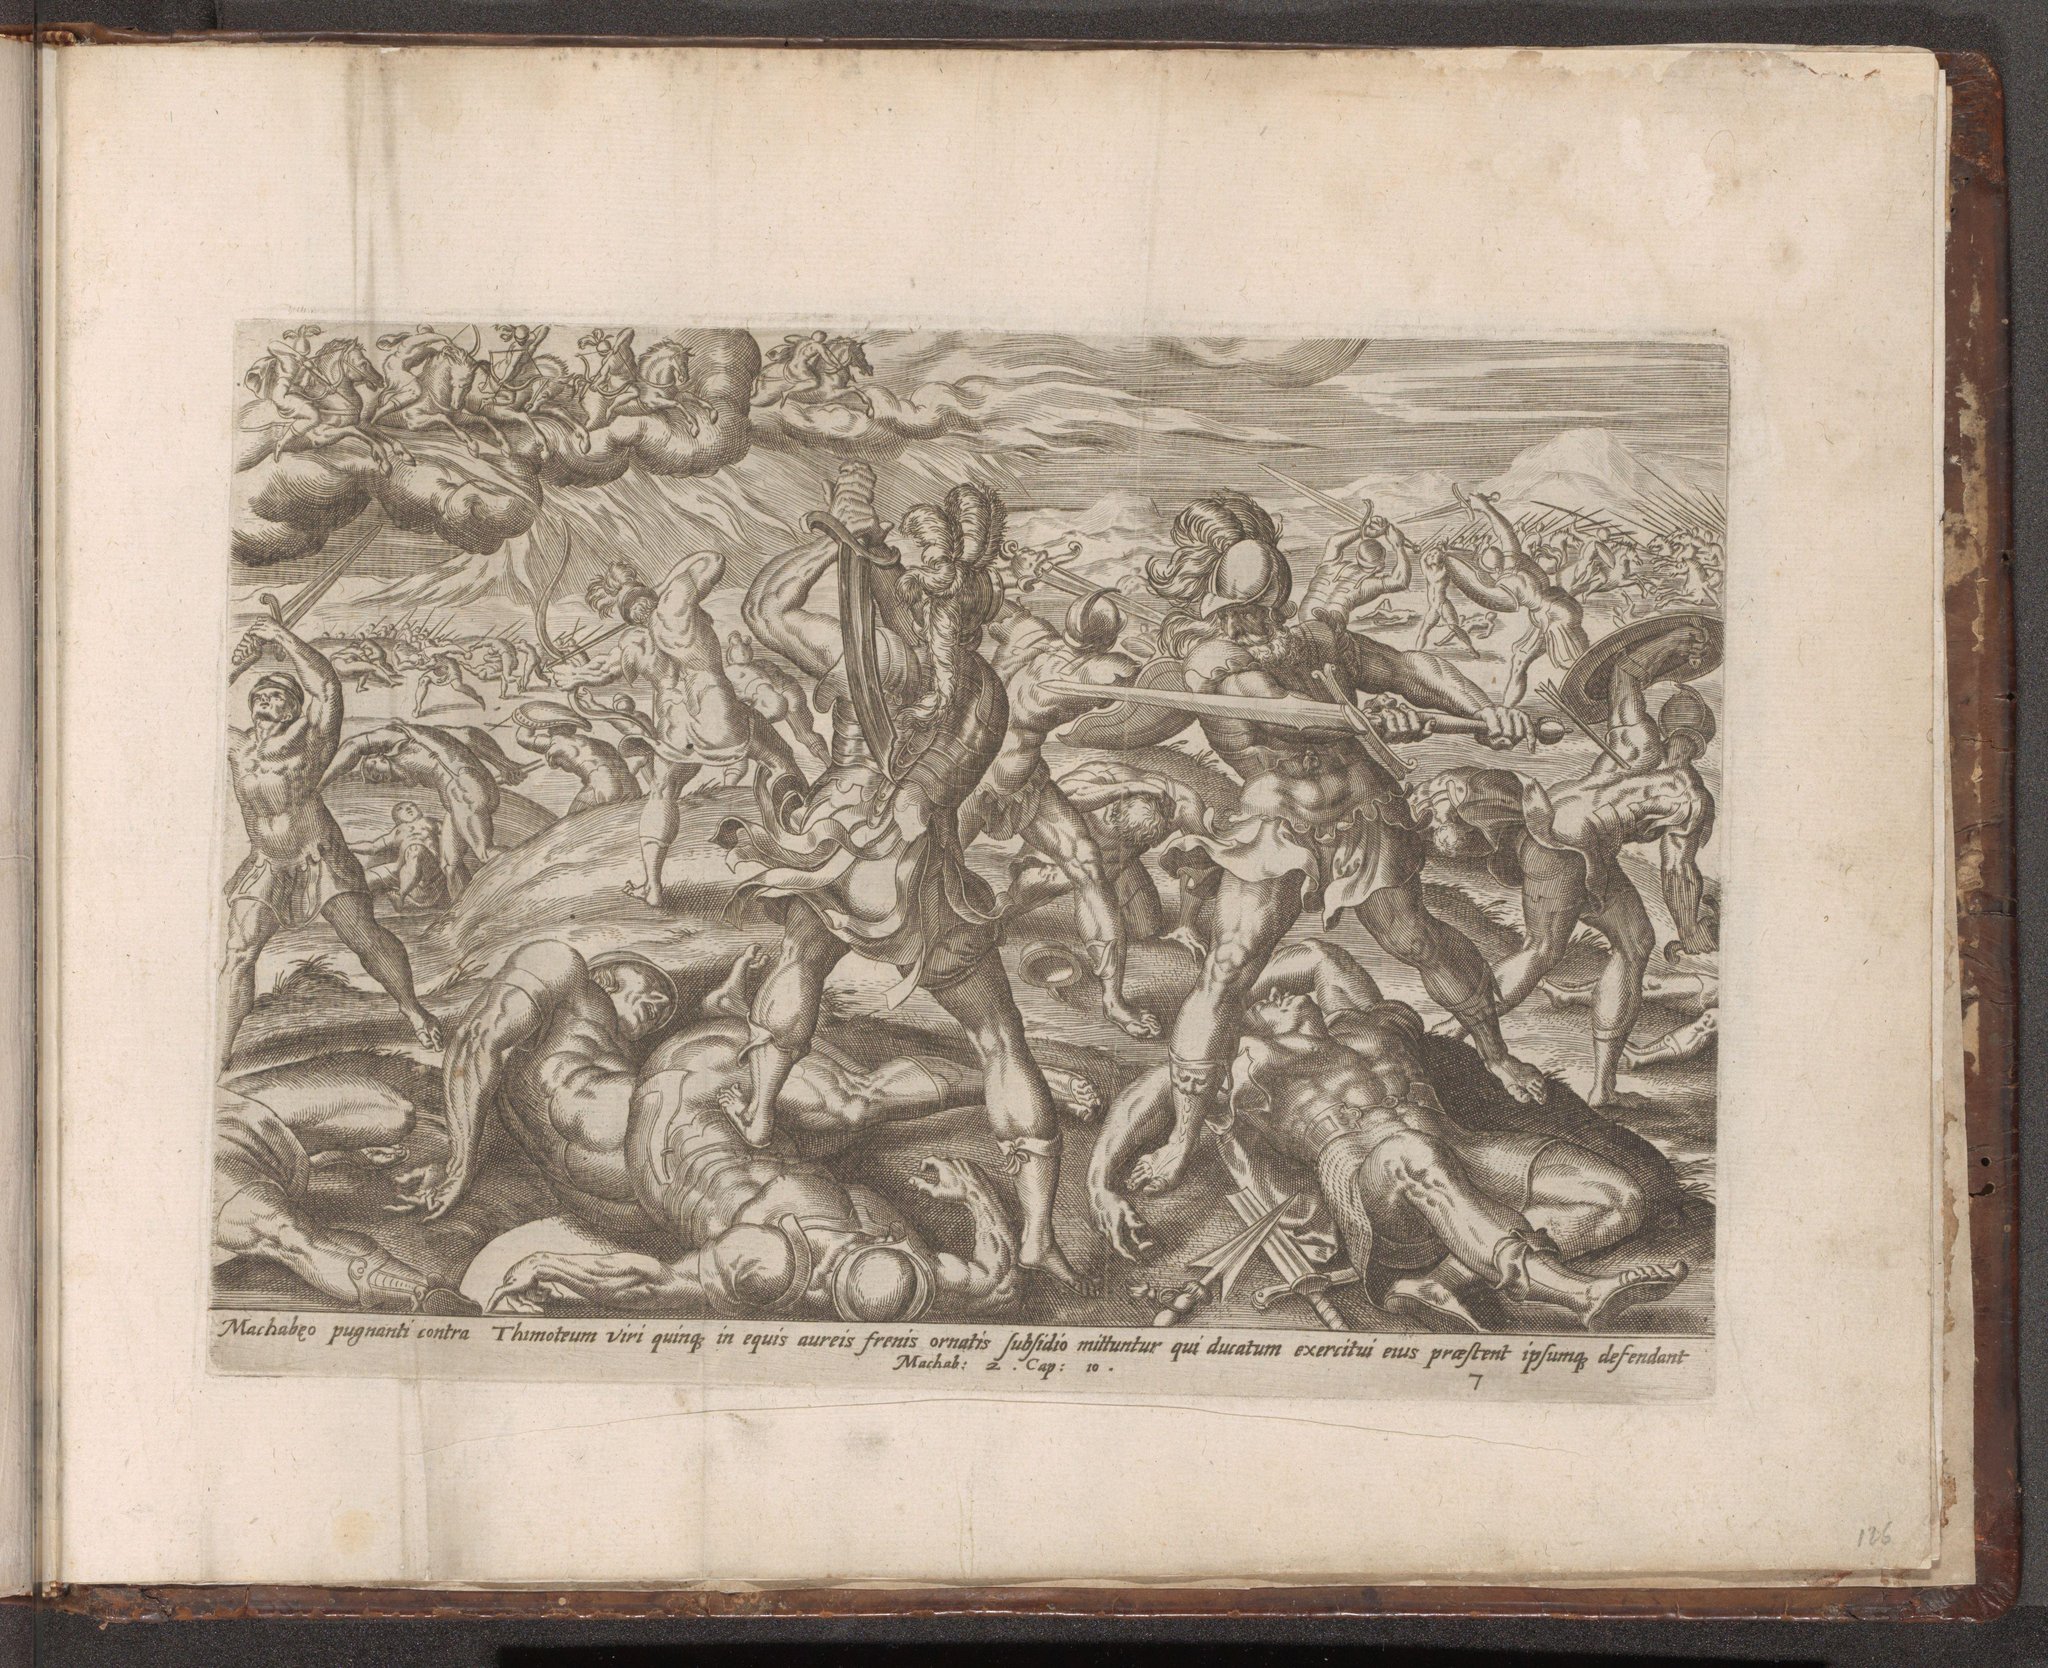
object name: album leaf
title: Geschiedenis van de Makkabeeën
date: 1579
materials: paper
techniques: engraving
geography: antwerp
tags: riders are seen in the sky above the city of jerusalem (2 maccabees 5:2)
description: Het leger van Timoteüs trekt op tegen Judea en vecht tegen de Joden. Aan de hemel verschijnen vijf ruiters op paarden met gouden teugels, die zich aan het hoofd stellen van de Joodse troepen. Ze bestoken de mannen van Timoteüs met pijlen en bliksem. Onder de voorstelling een verwijzing in het Latijn naar de Bijbeltekst in 2 Makk. 10:29. Prent maakt deel uit van een album.